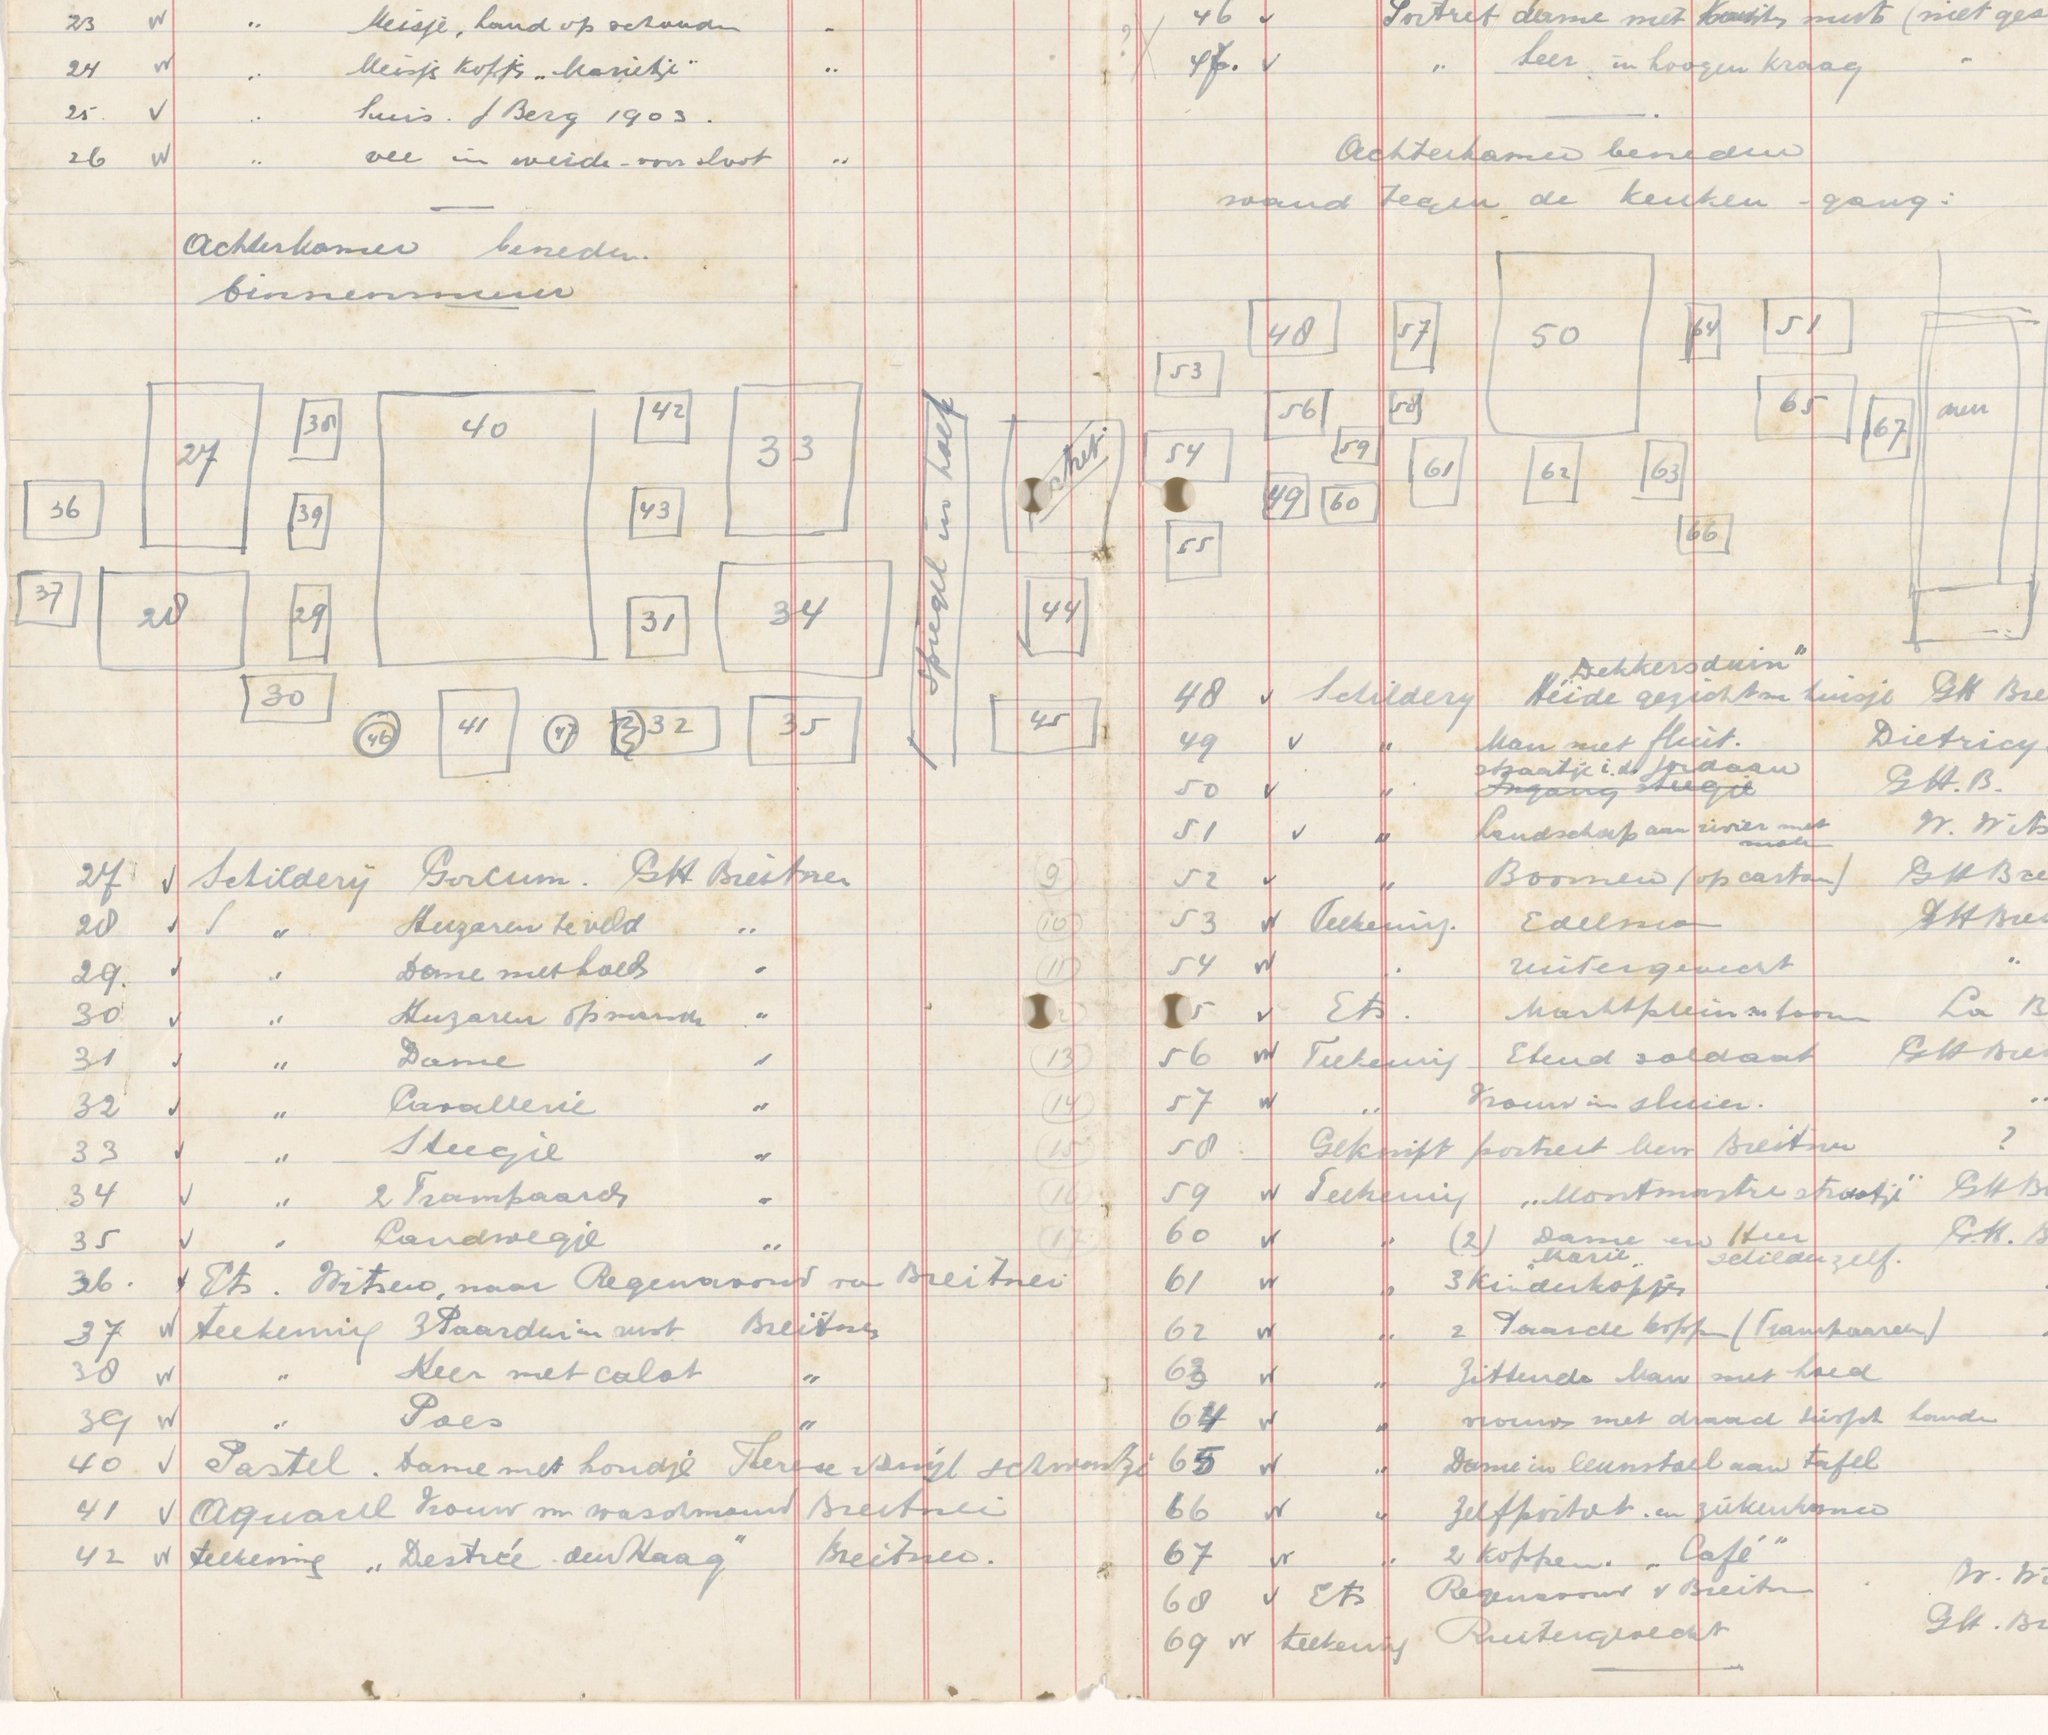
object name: document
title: Schema van de hanging van Breitners schilderijen met toelichting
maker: george hendrik breitner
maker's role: draughtsman, painter, print maker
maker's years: 1857-1923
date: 1942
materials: ink, paper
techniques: pen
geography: zeist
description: Inventarisatie van kunstwerken per kamer in het huis van Marie Breitner-Jordan aan de Dalweg 9 in Zeist.